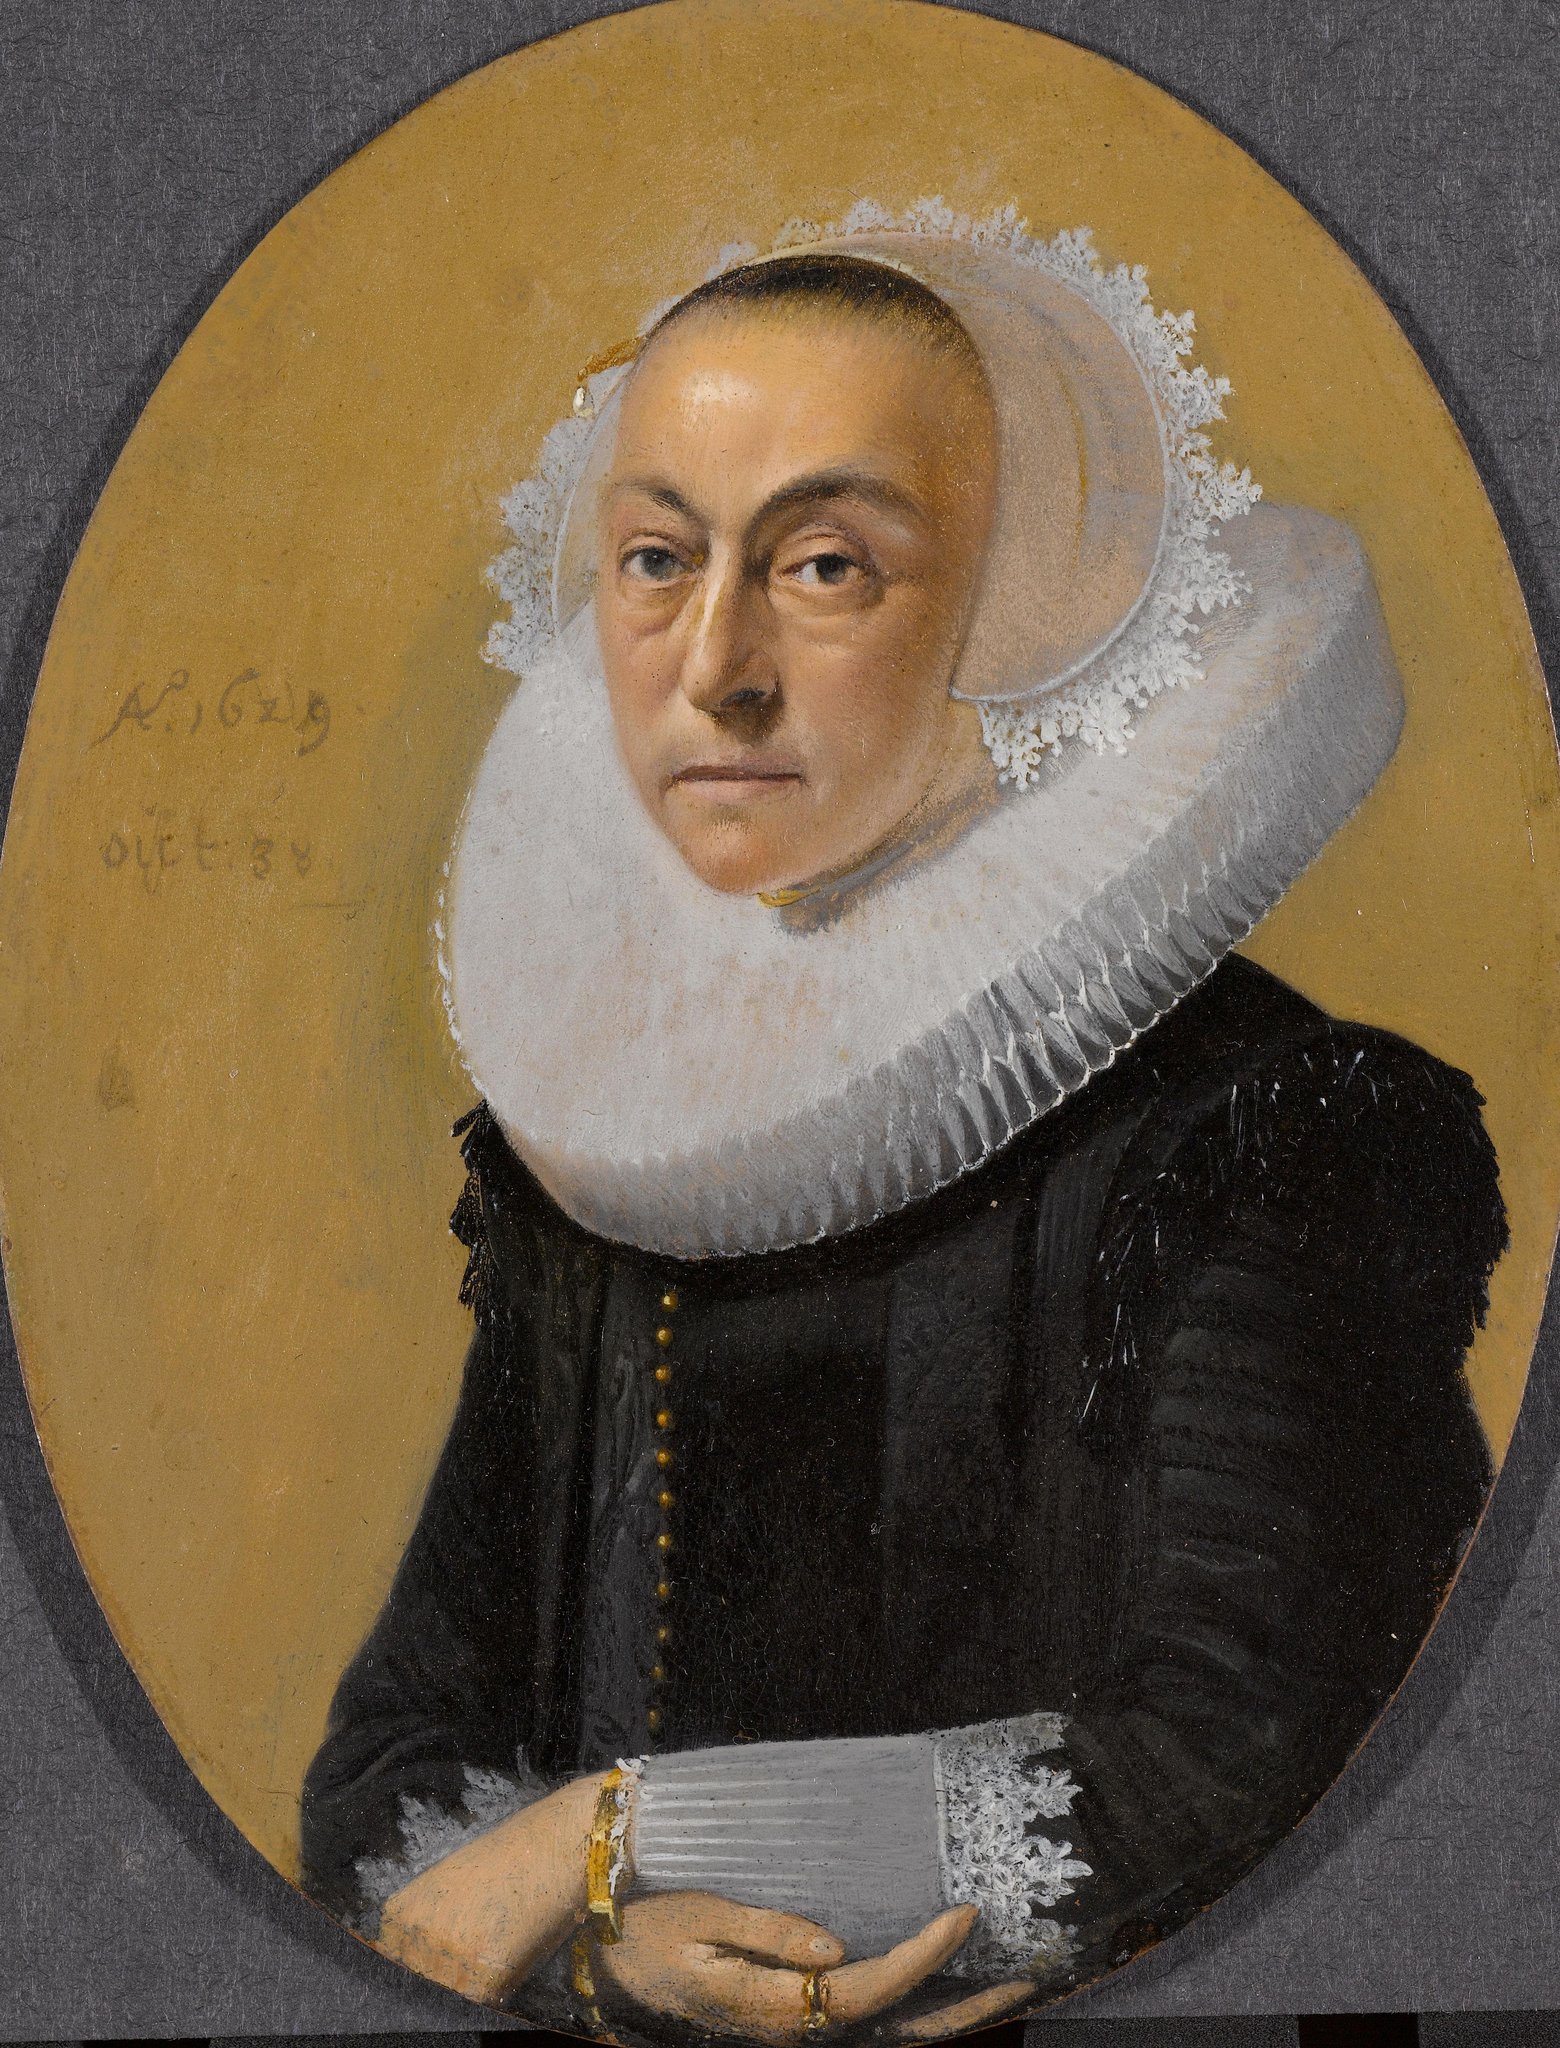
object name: painting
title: Portrait of a Woman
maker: willem cornelisz duyster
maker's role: draughtsman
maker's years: 1599-1635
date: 1629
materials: copper, oil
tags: historical persons not known by name - bb - woman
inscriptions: inscription and date, centre left: ‘Aº. 1629. / out: 38.’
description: Ovaal portretje van een vrouw. Buste met de handen gevouwen voor de buik. Pendant van SK-A-1791.